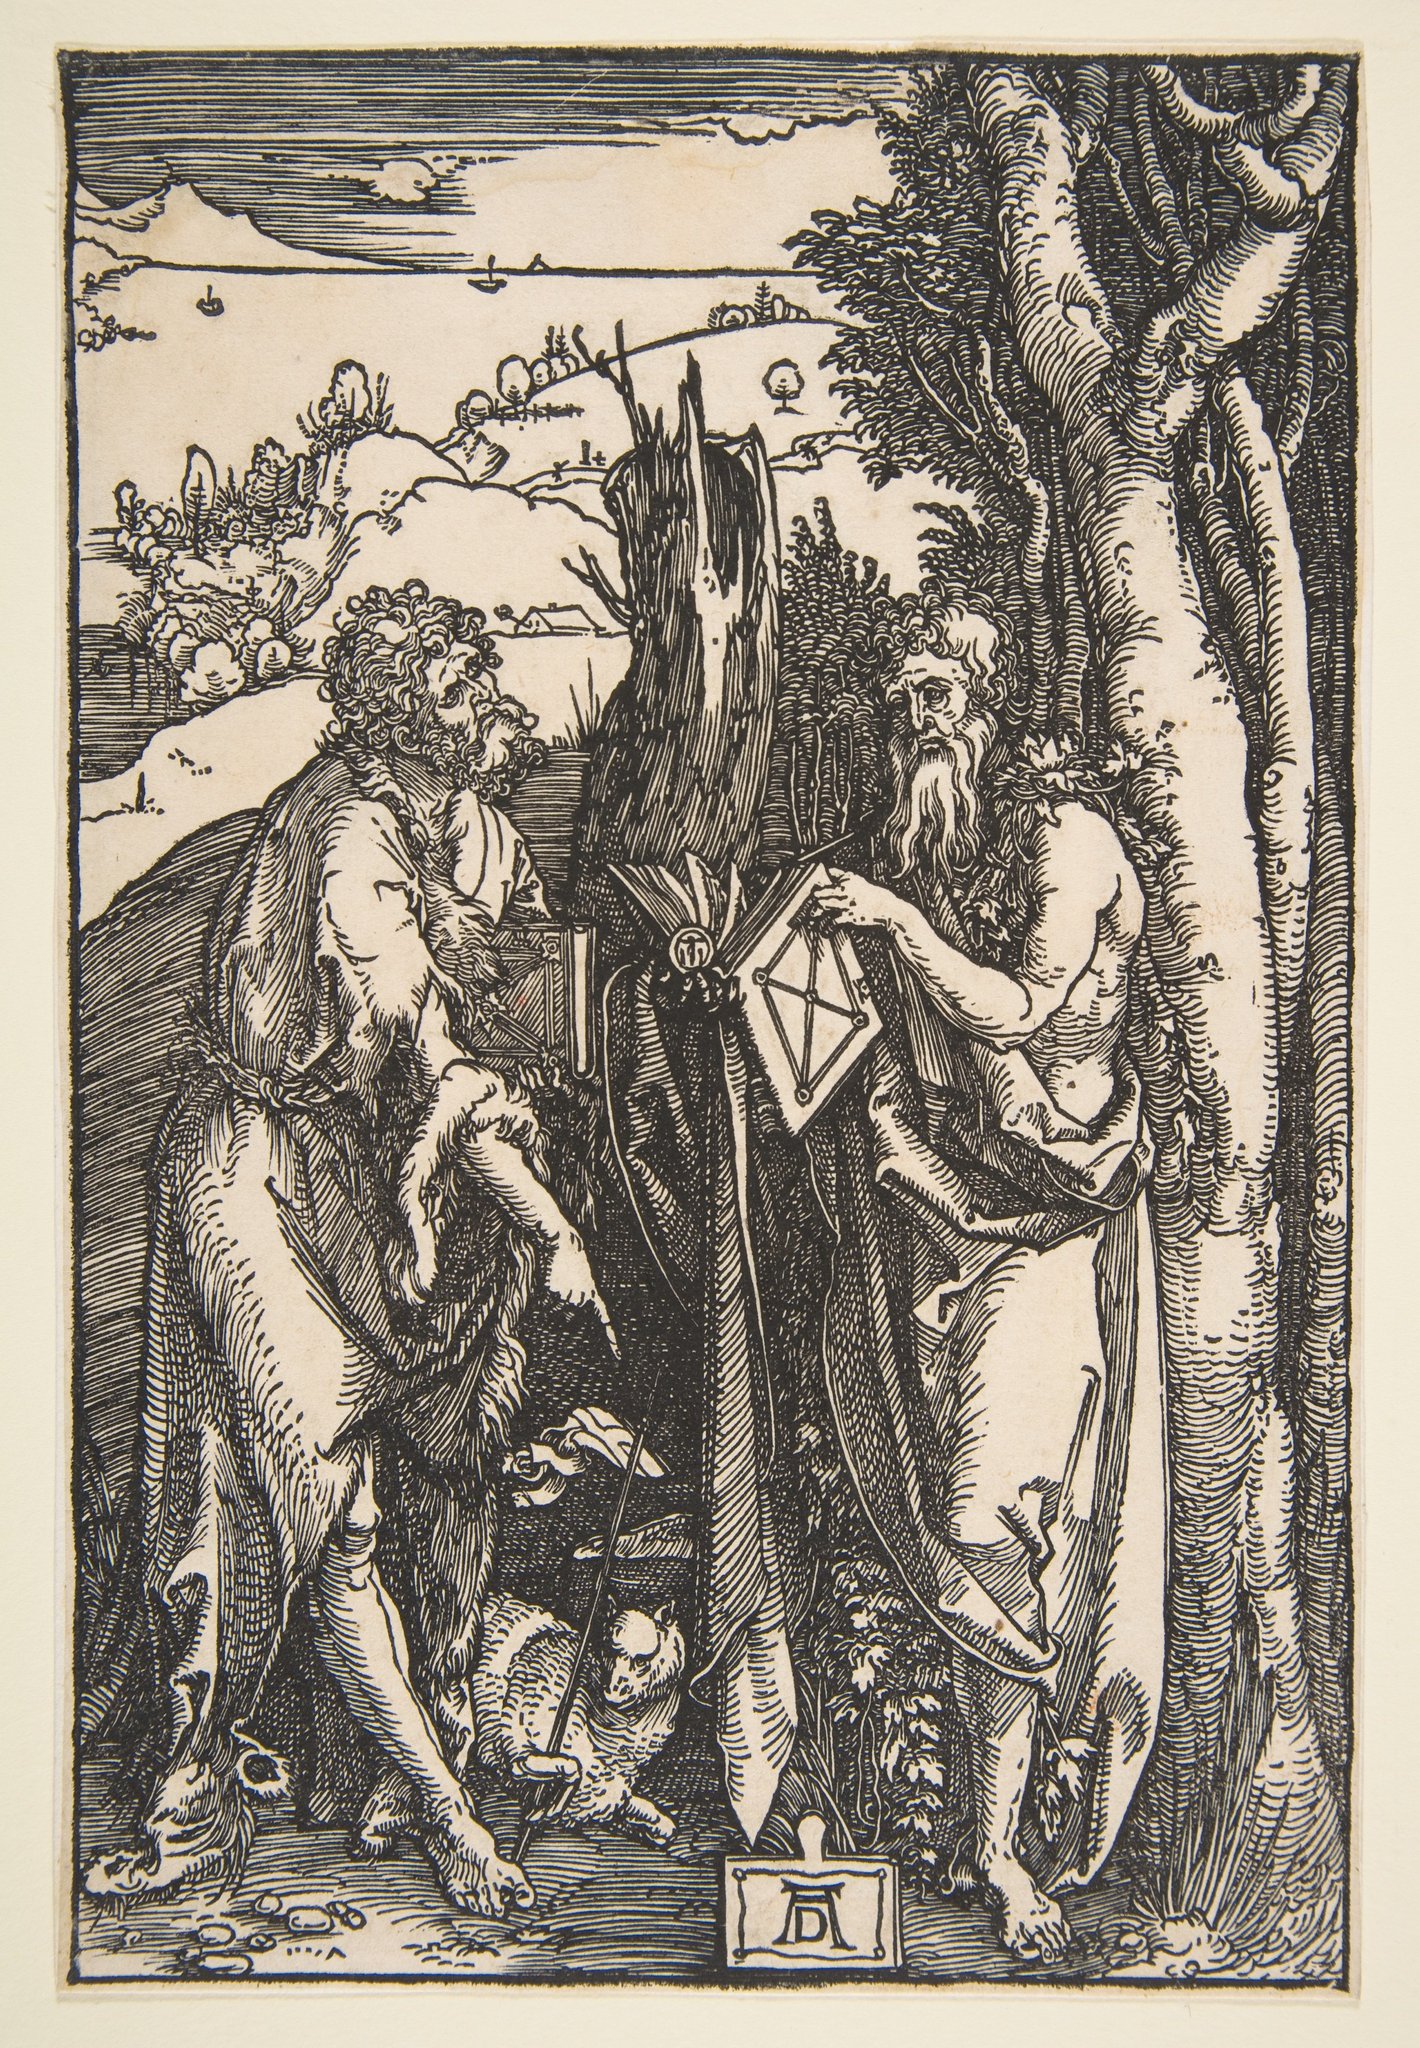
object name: print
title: Saint John the Baptist and Saint Onuphrius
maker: albrecht dürer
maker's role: artist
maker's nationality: german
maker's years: 1471-1528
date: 1503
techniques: woodcut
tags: animals,trees,saint john the baptist